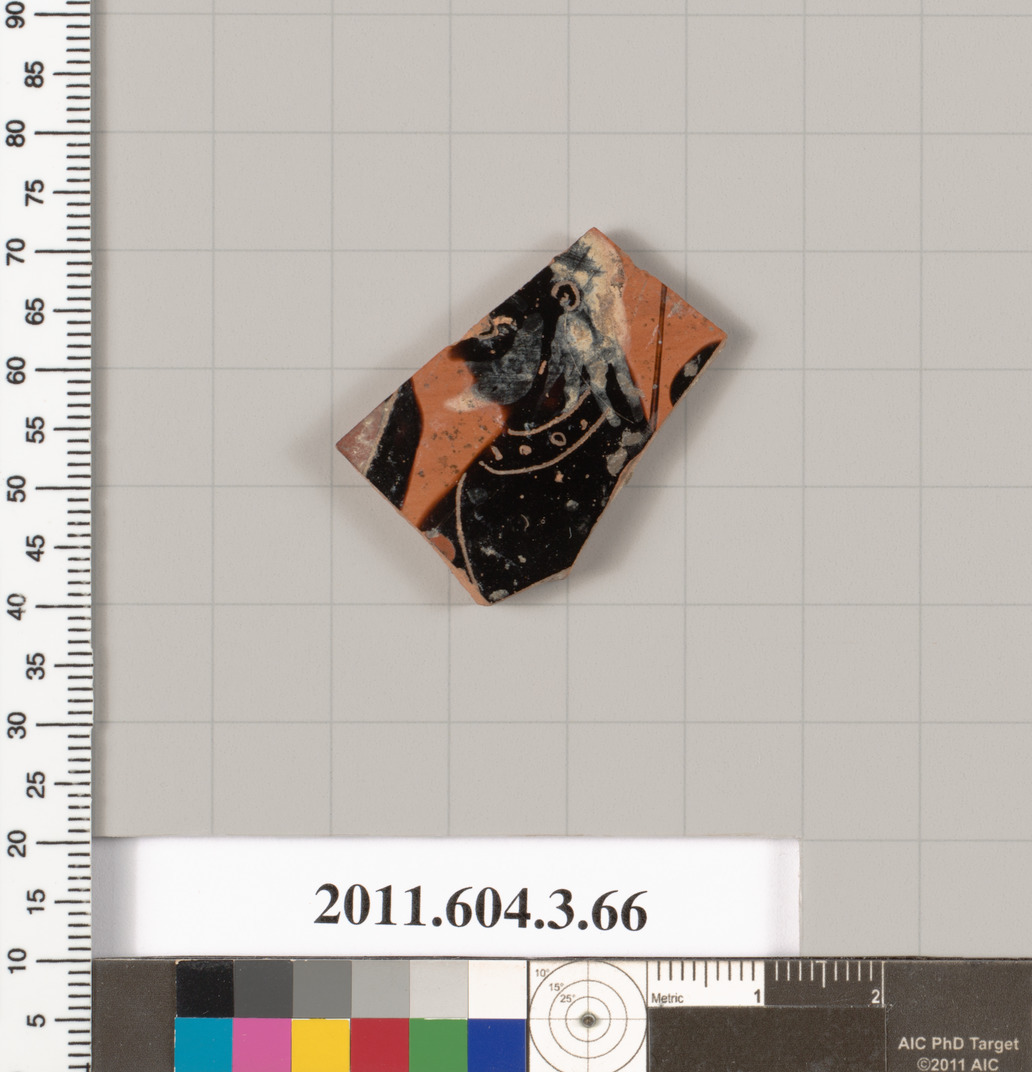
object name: amphora fragment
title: Terracotta fragment of an amphora (jar)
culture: greek, attic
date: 500-468 BCE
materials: terracotta